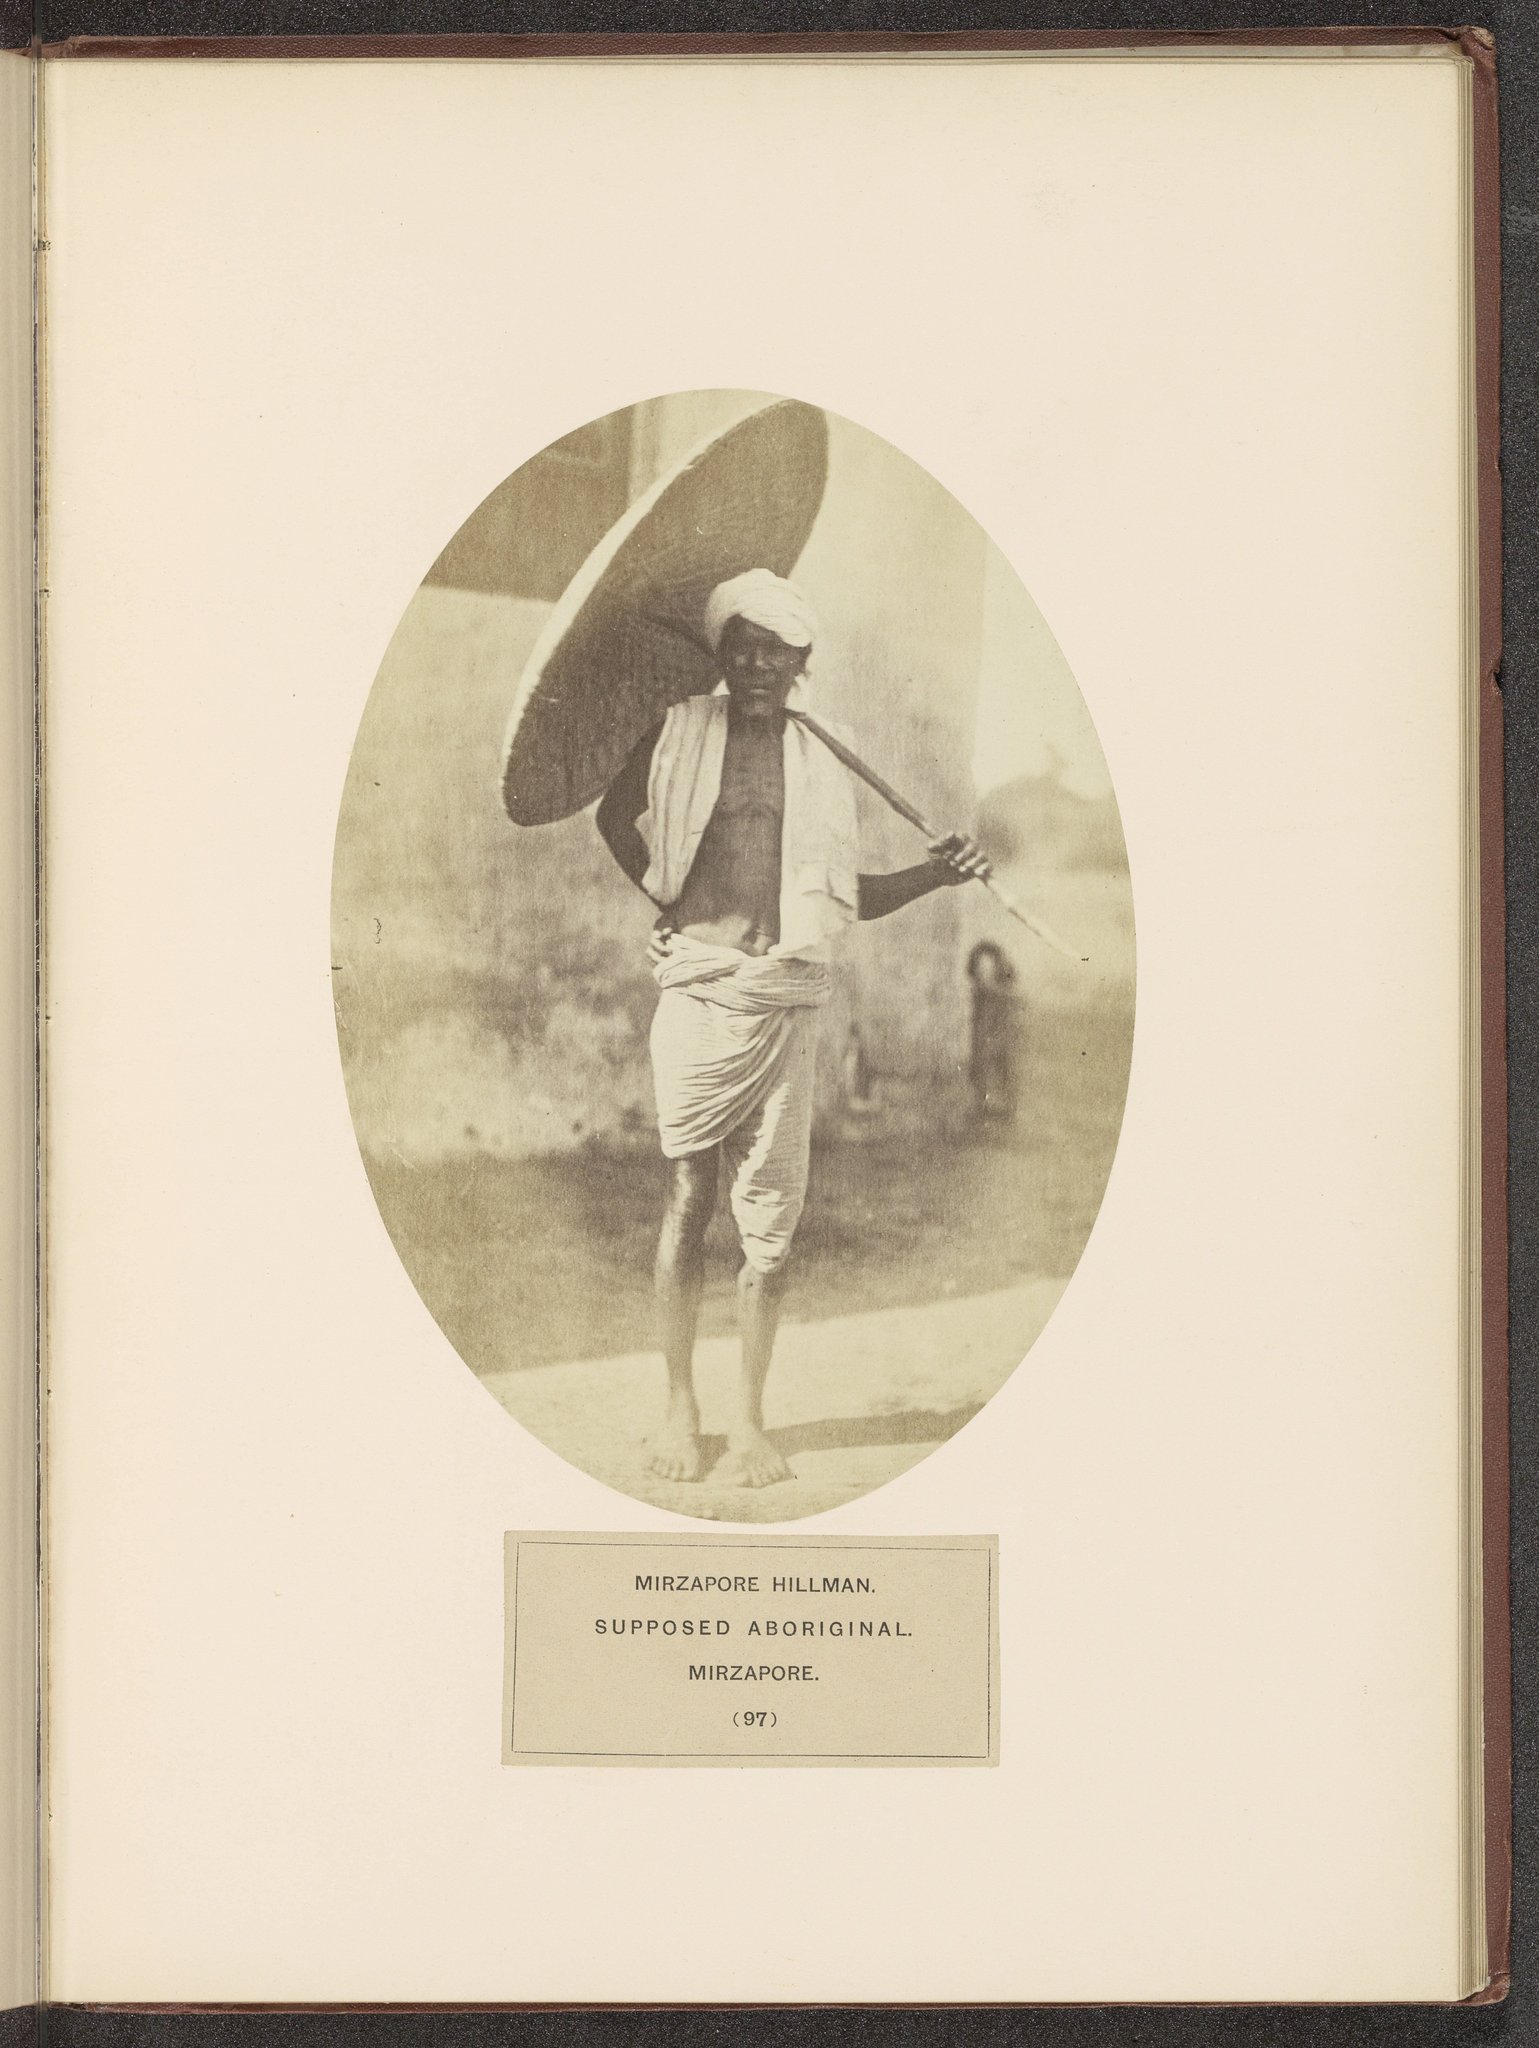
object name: page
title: Portrait of an unknown man with an umbrella from Mirzapur, Uttar Pradesh, India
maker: Anonymous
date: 1858-1868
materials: photographic support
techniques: albumen print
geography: mirzapur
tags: human races; peoples; nationalities, parasol, sunshade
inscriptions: number: ‘(97)’, inscription: ‘MIRZAPORE HILLMAN./ SUPPOSED ABORIGINAL./ MIRZAPORE.’